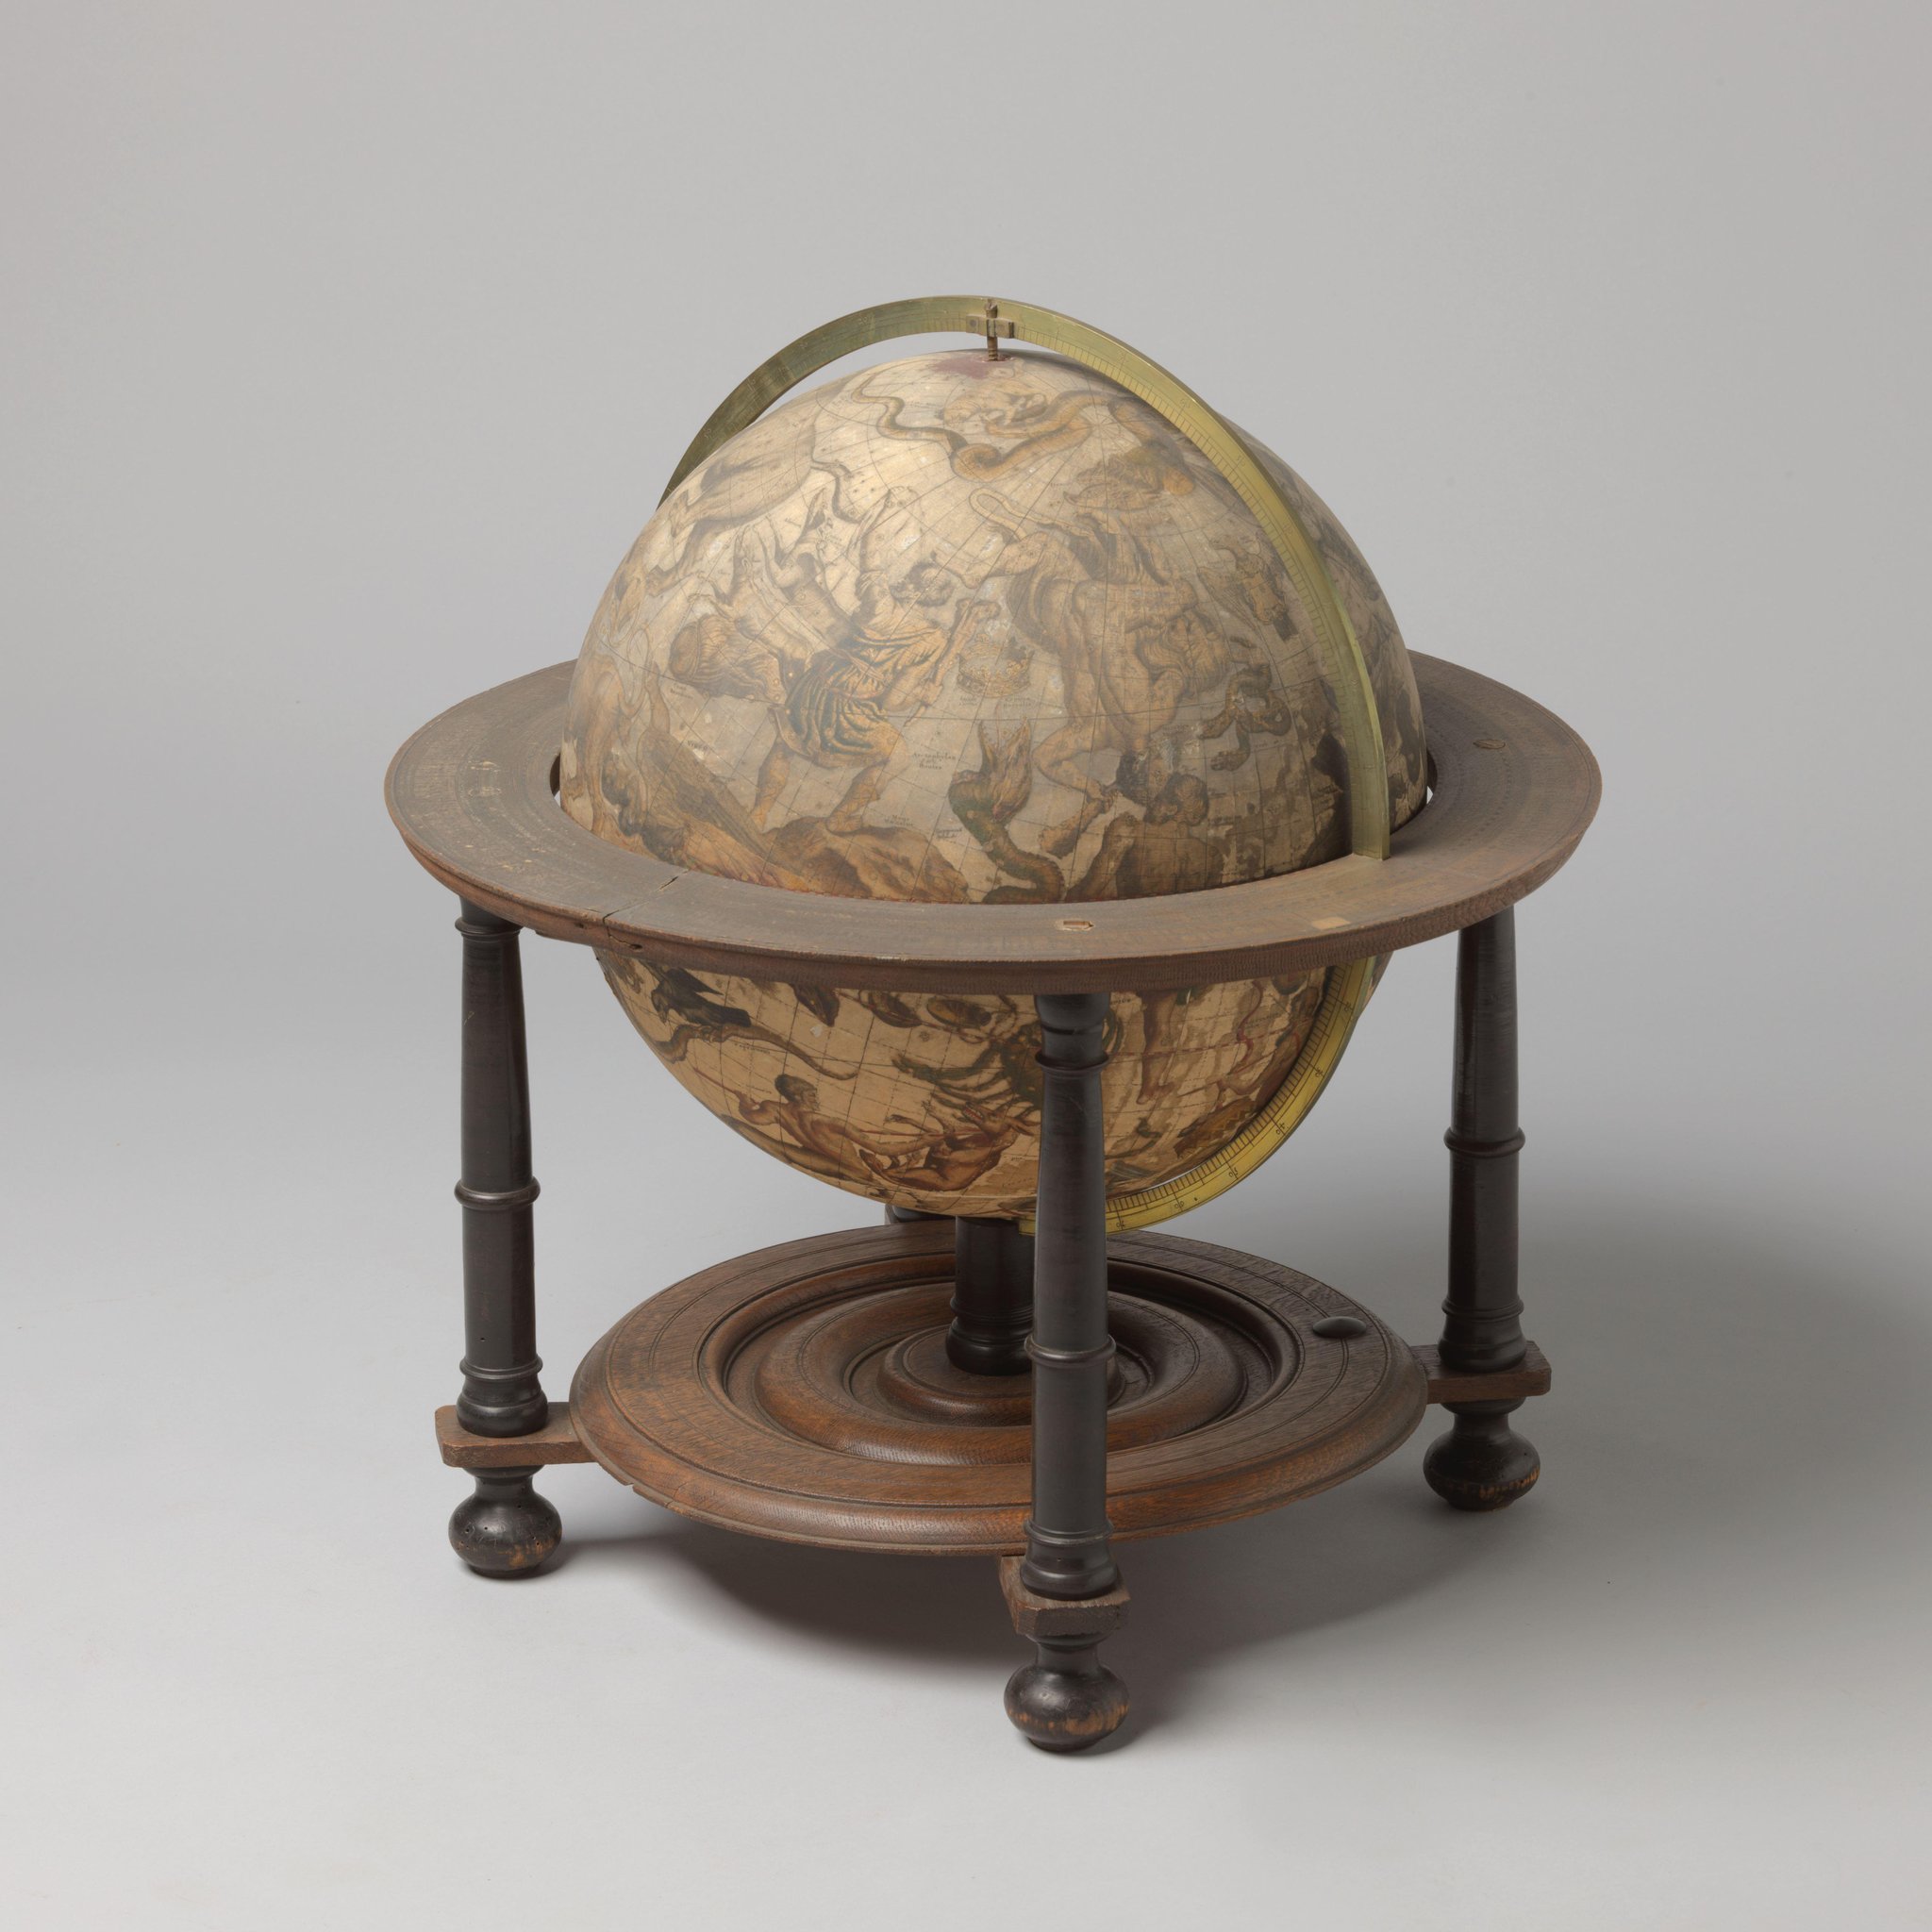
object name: hemelglobe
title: Hemelglobe gemaakt door G. Valck of Valk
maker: gerard valck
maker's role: print maker, publisher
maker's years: 1651-1726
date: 1650-1700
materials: copper, wood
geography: netherlands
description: Hemelglobe gemaakt door G. Valck of Valk.